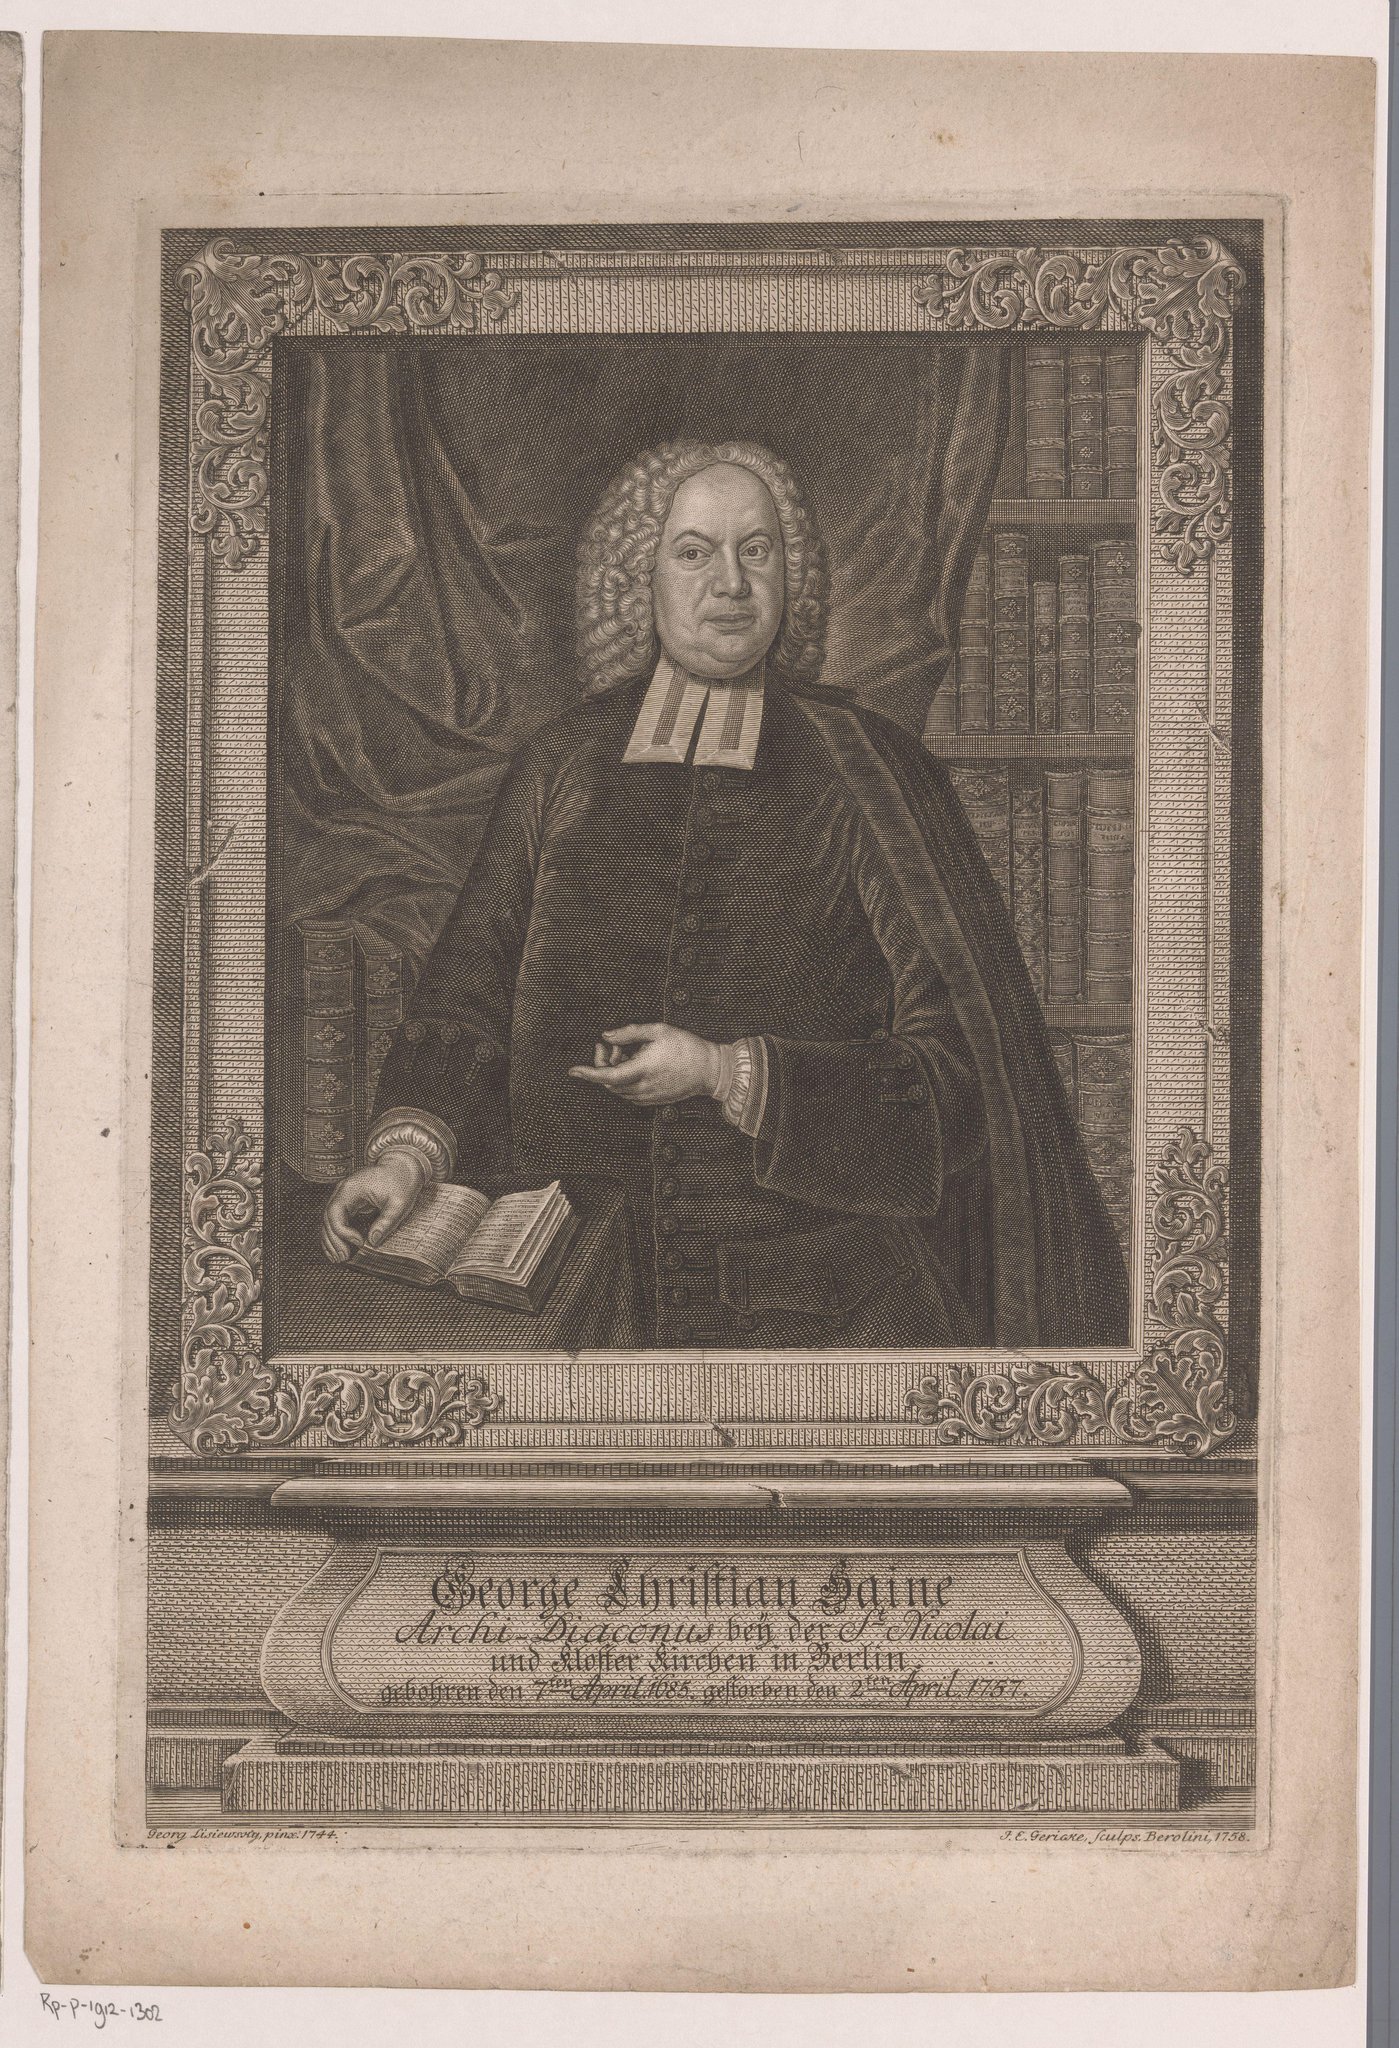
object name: print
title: Portret van Georg Christian Haine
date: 1744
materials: paper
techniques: engraving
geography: berlin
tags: bookshelves, theologian, historical persons, ornament derived from architectural details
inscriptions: collector's mark: Lugt 2228